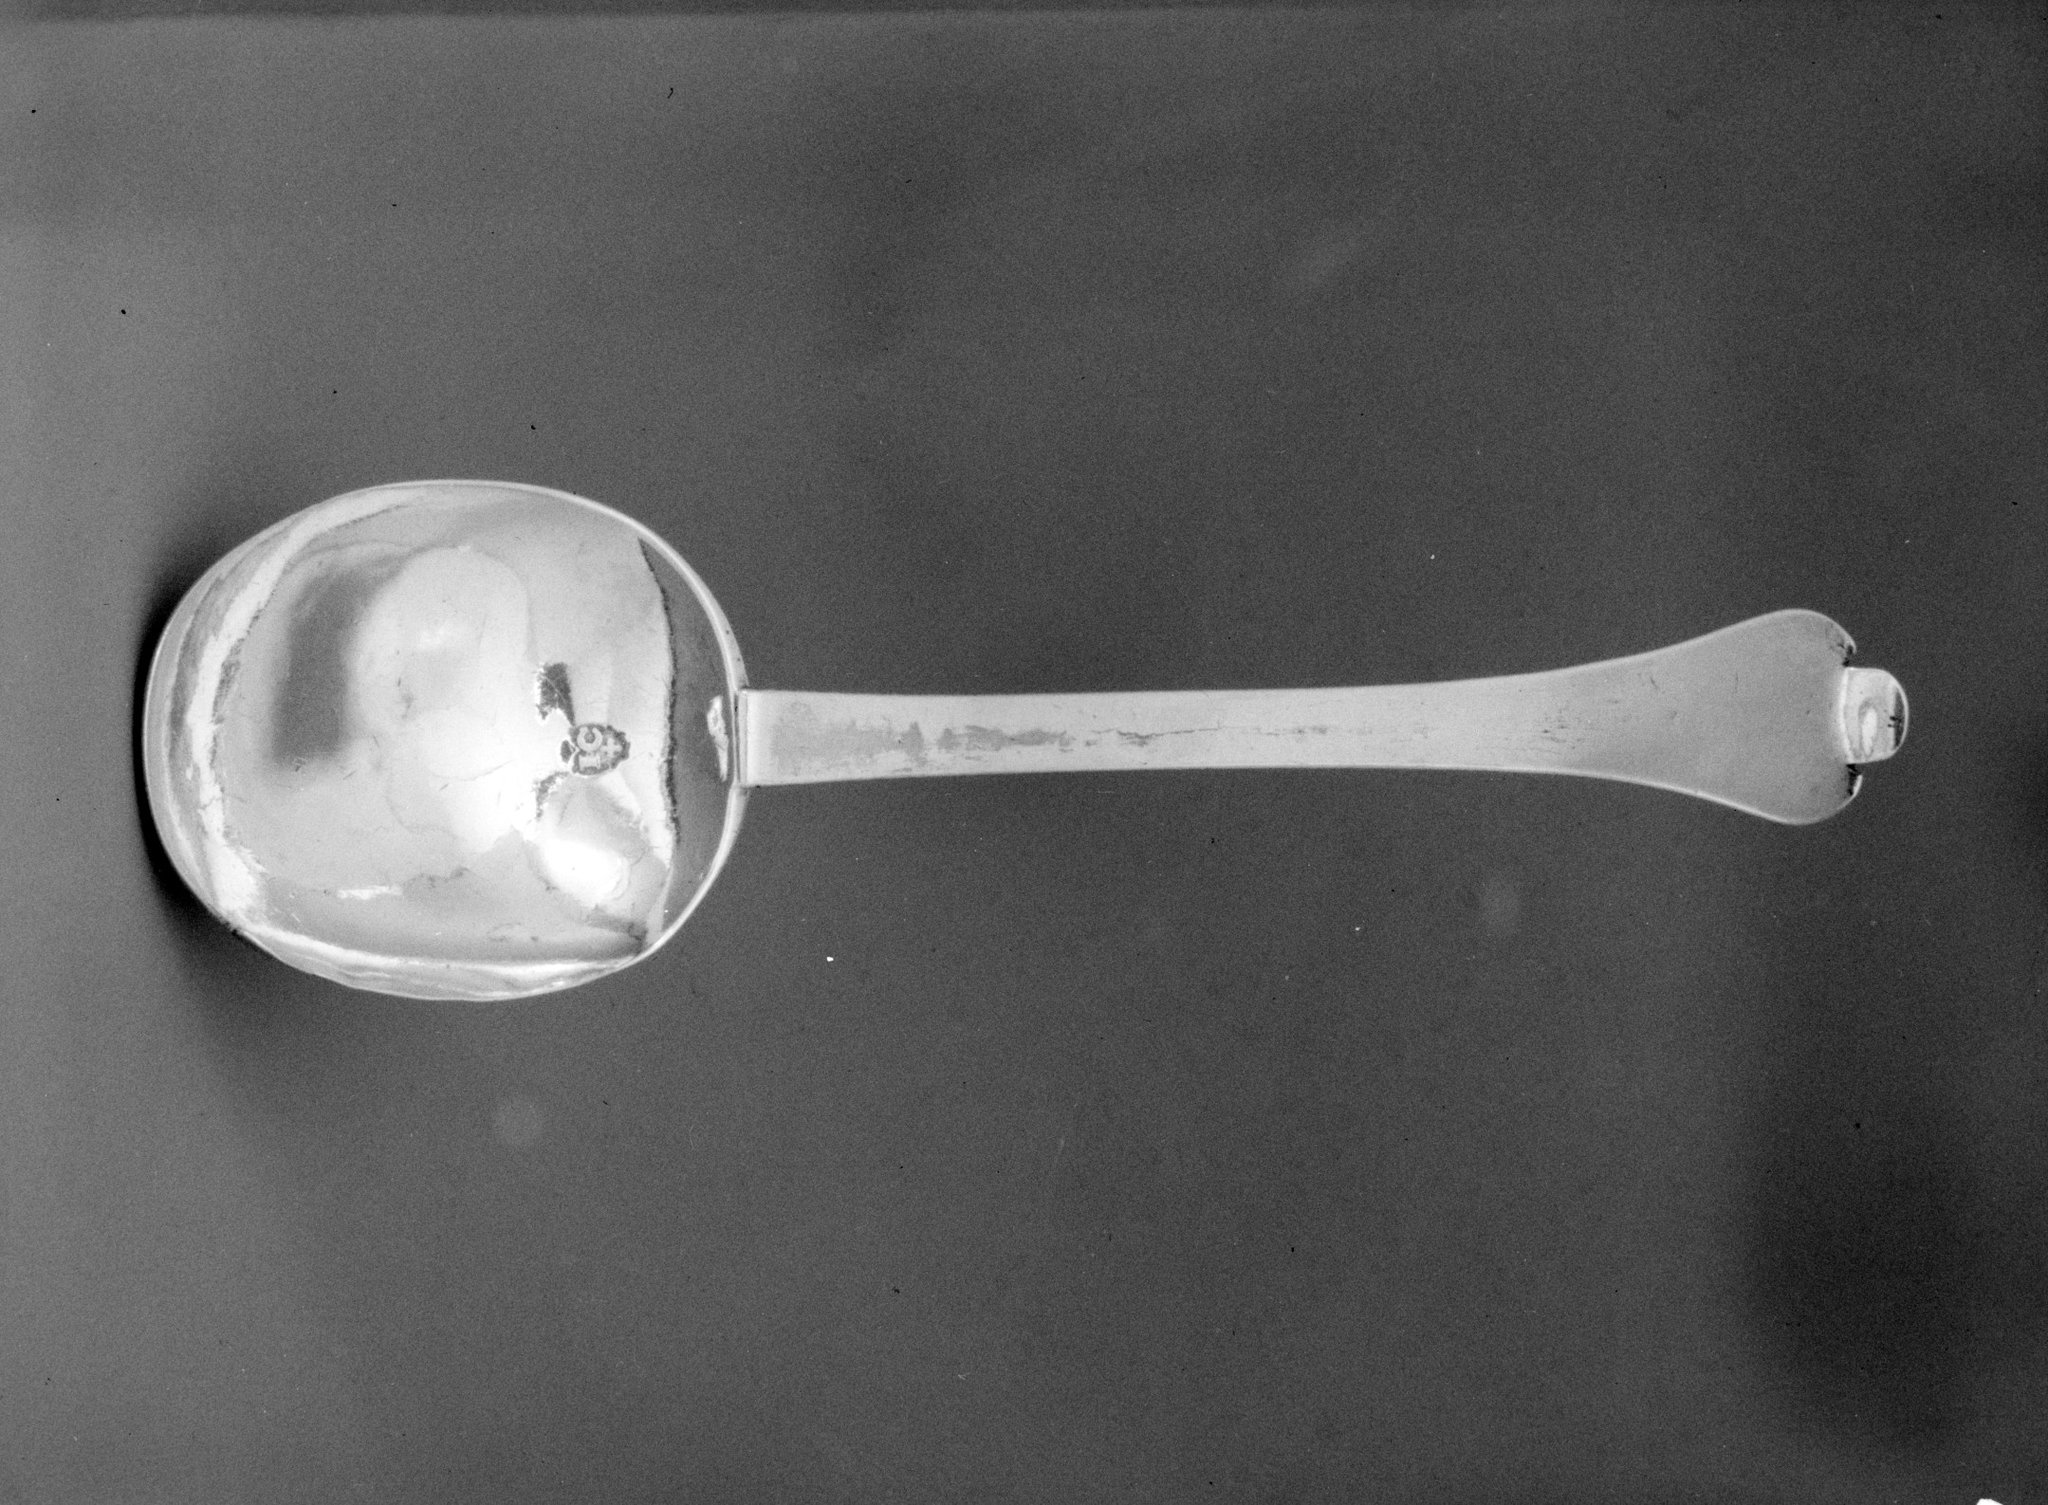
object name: spoon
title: Funeral Spoon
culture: american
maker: john coney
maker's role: maker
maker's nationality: american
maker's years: 1655-1722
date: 1670-1730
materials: silver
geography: united states